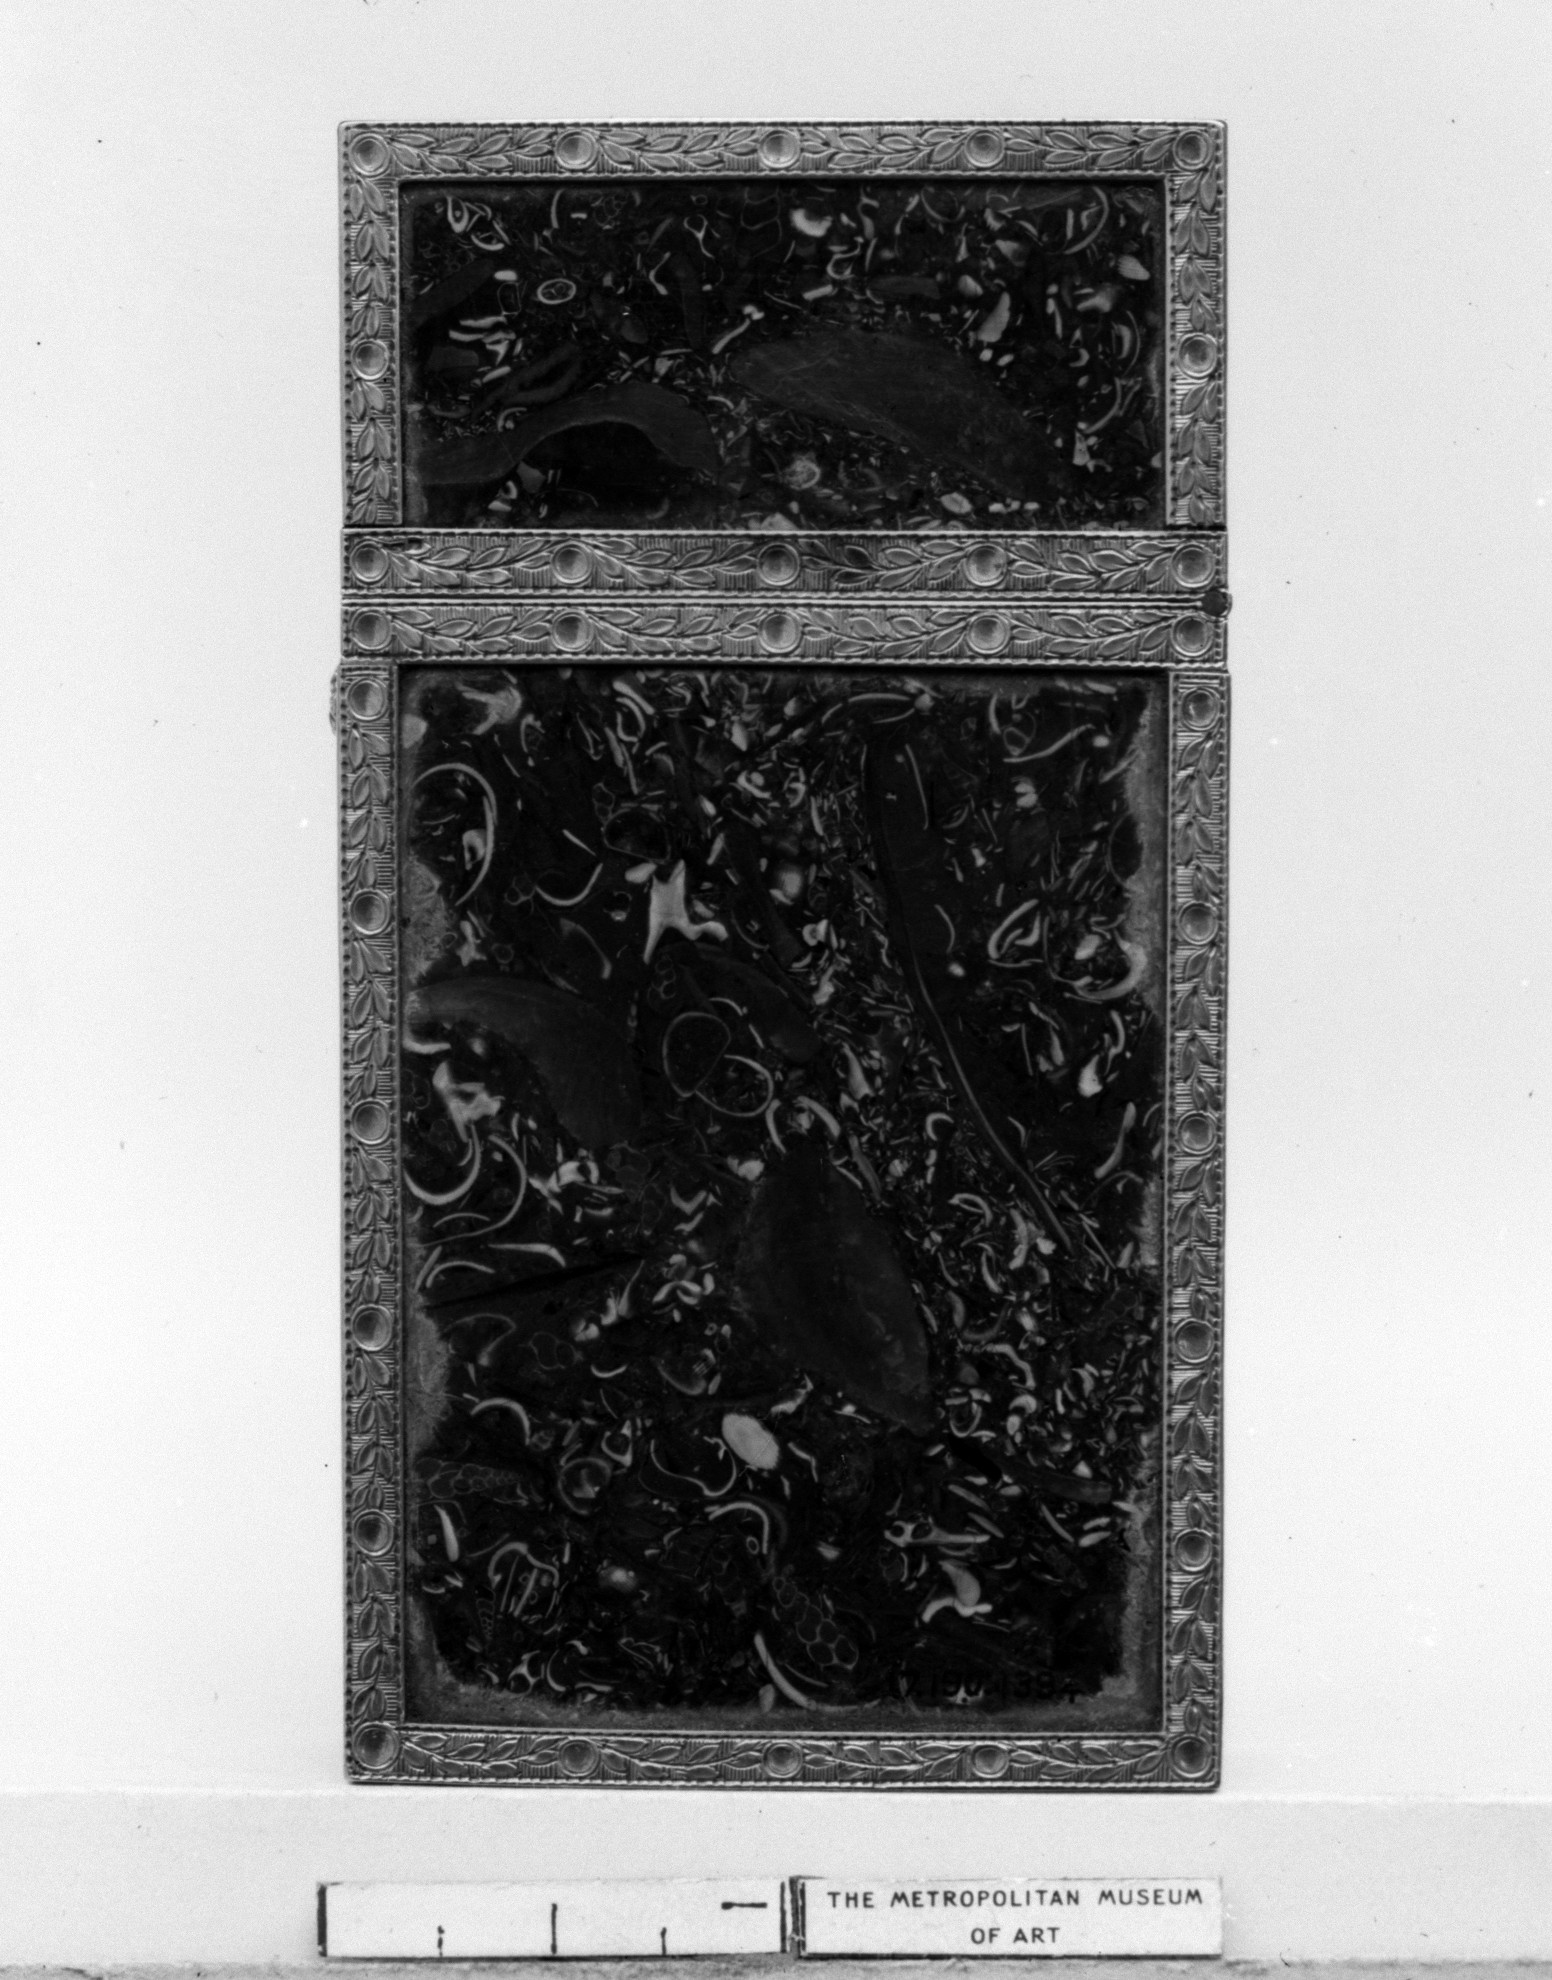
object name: souvenir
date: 1701-1800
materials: gold